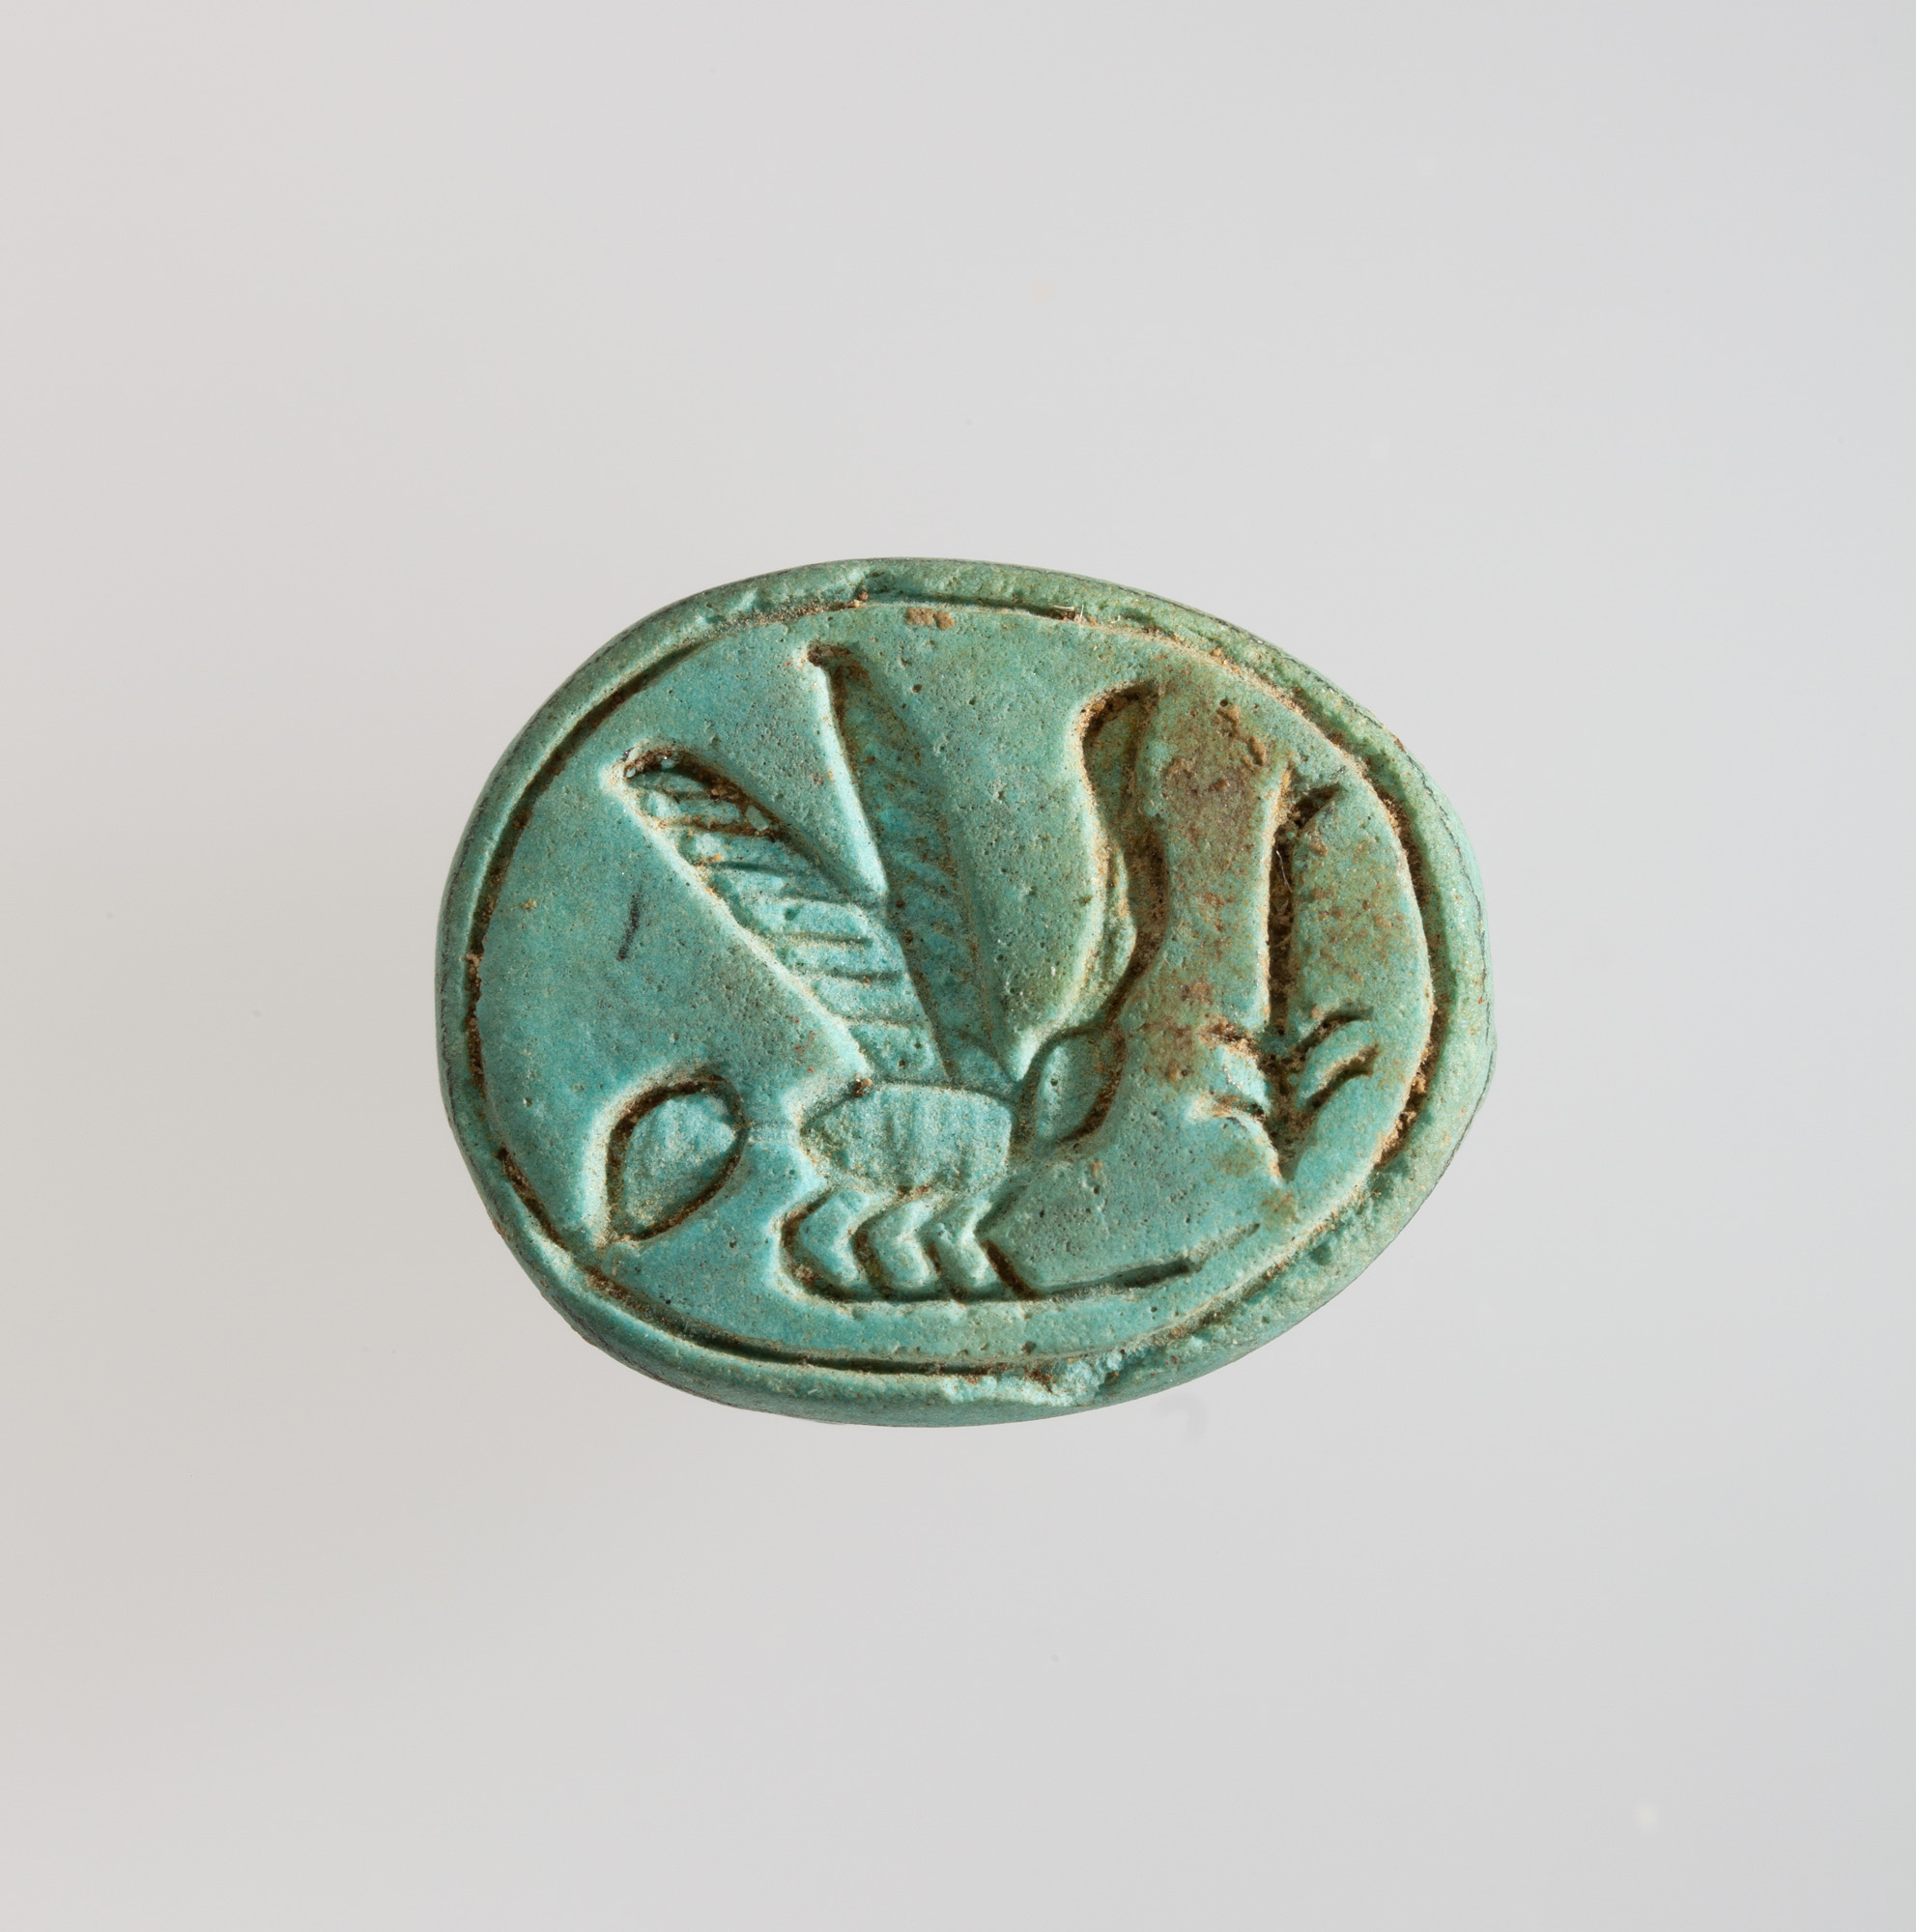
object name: scarab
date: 1479-1458 BCE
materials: faience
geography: egypt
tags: scarabs